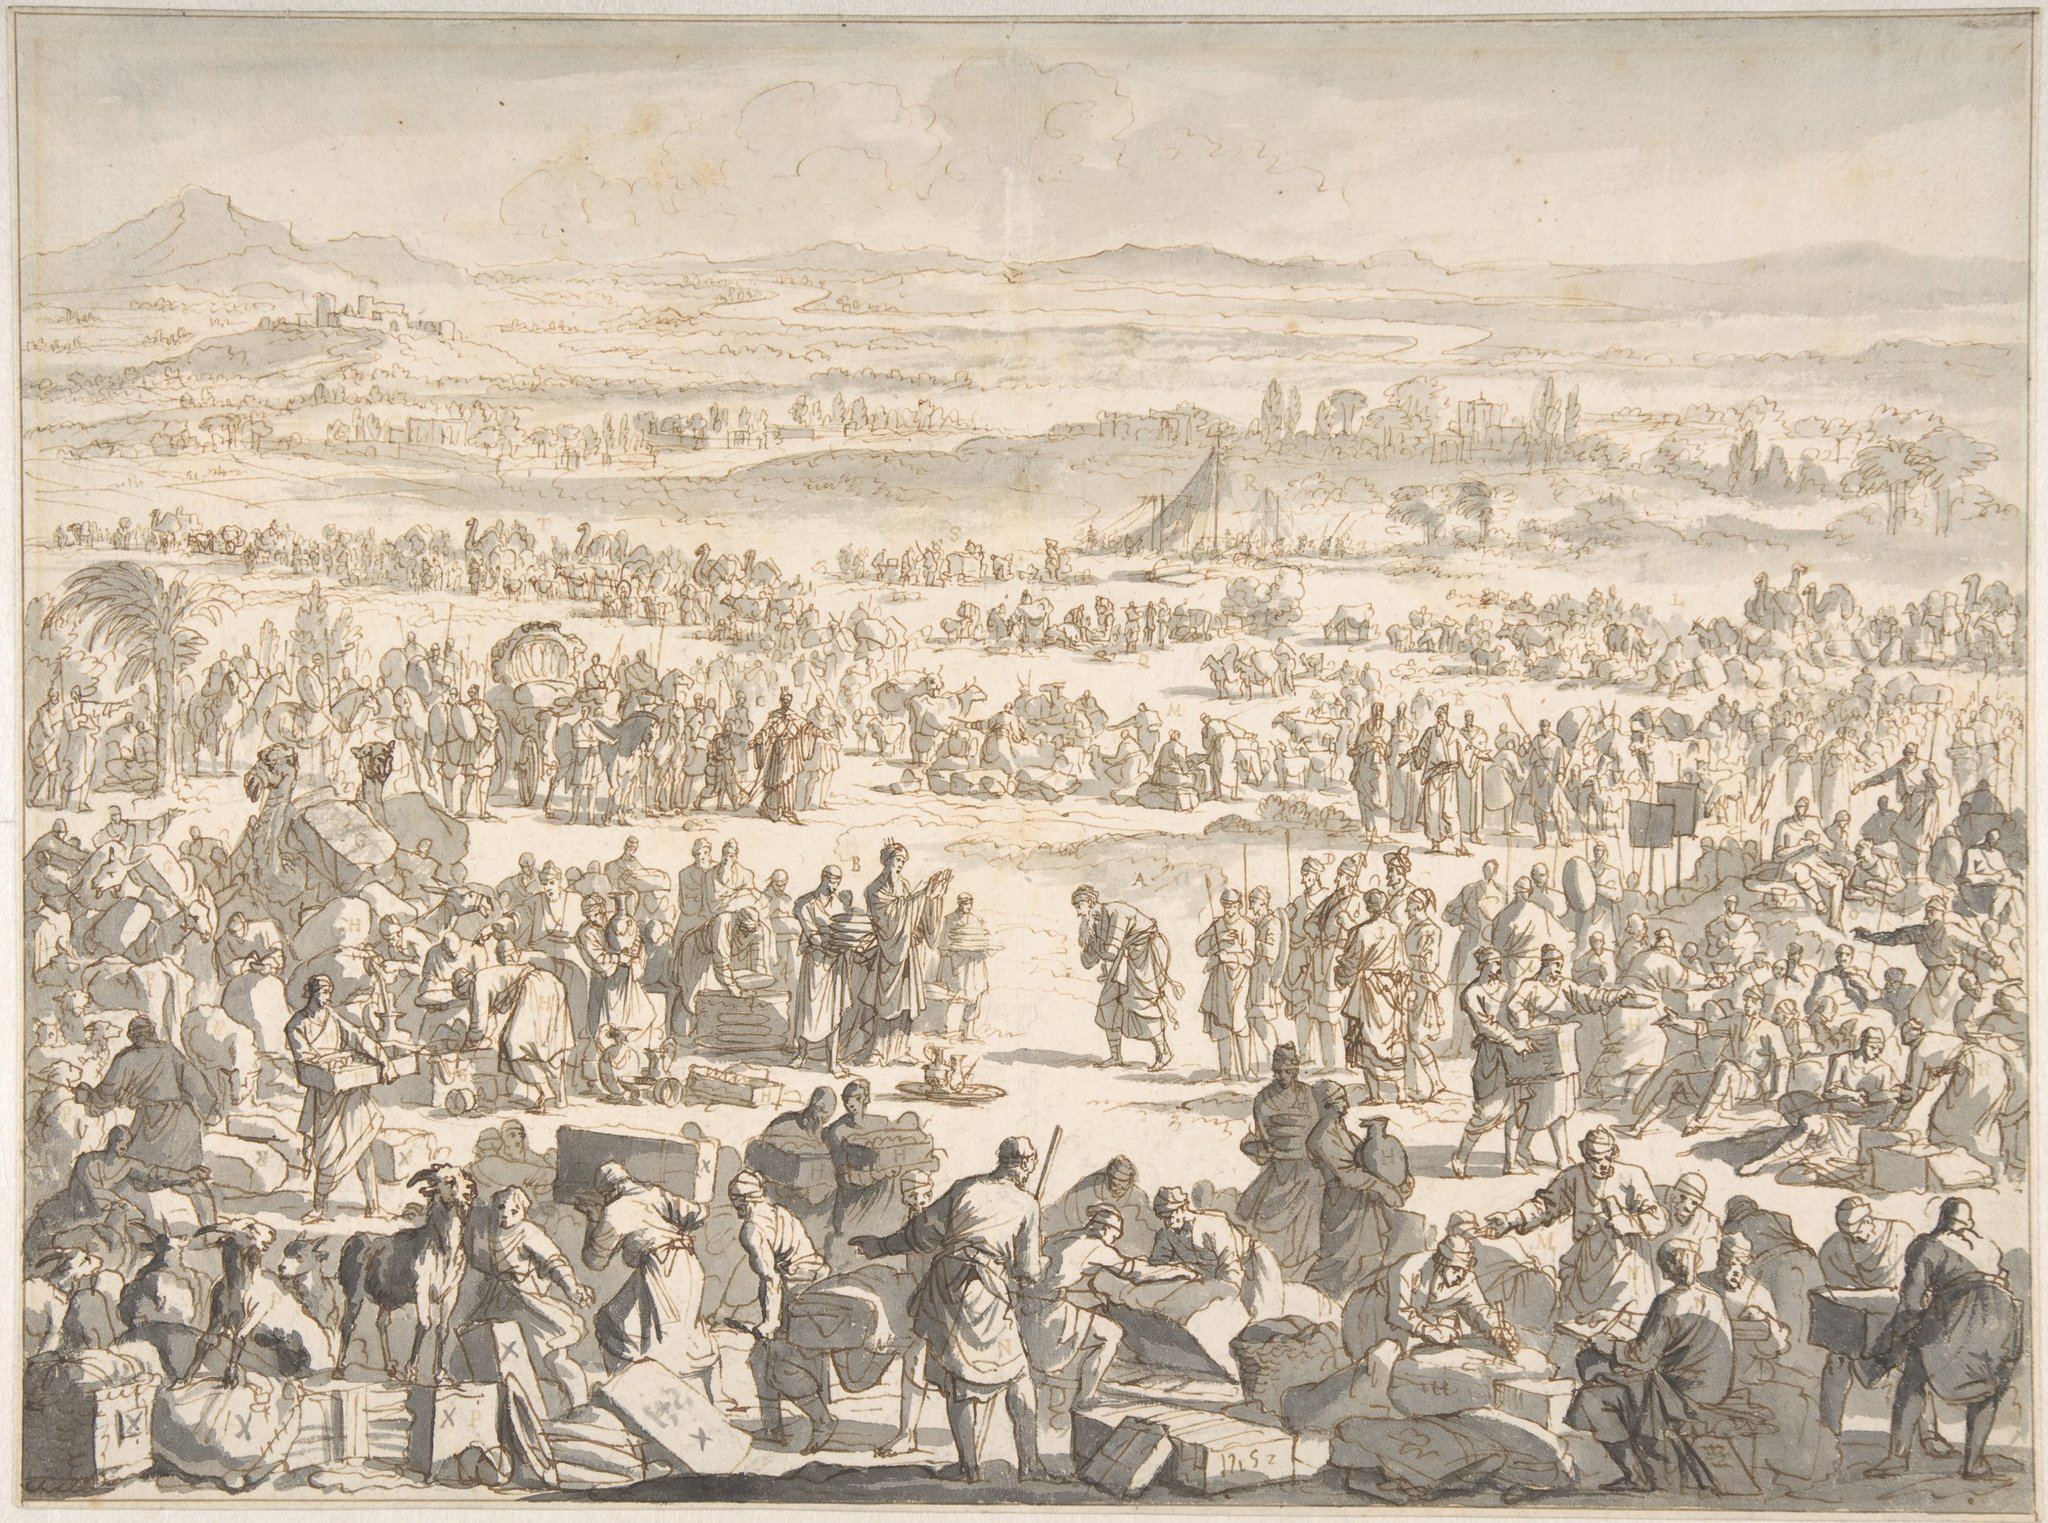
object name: drawing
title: Melchizedek Blessing Abraham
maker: jan luyken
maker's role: artist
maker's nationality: dutch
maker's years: 1649-1712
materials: ink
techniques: brush, pen, wash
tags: men,goats,hills,abraham